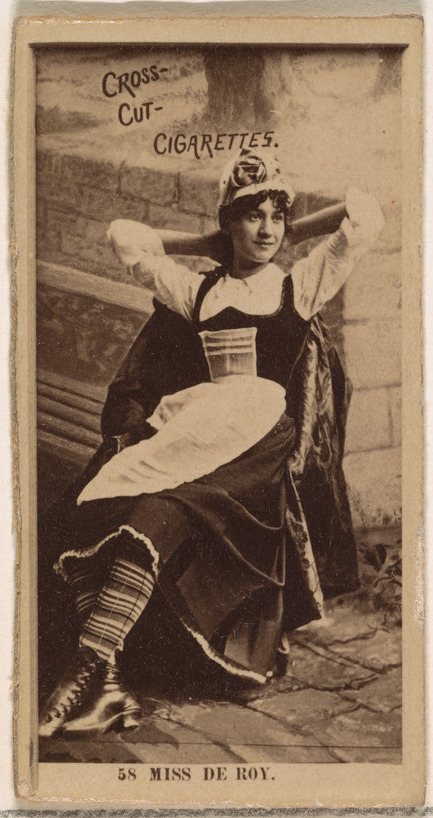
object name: print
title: Card Number 58, Miss De Roy, from the Actors and Actresses series (N145-2) issued by Duke Sons & Co. to promote Cross Cut Cigarettes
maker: w. duke, sons & co.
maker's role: publisher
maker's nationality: american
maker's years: 1870-1920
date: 1880-1889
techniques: albumen silver print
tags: portraits,women,actresses